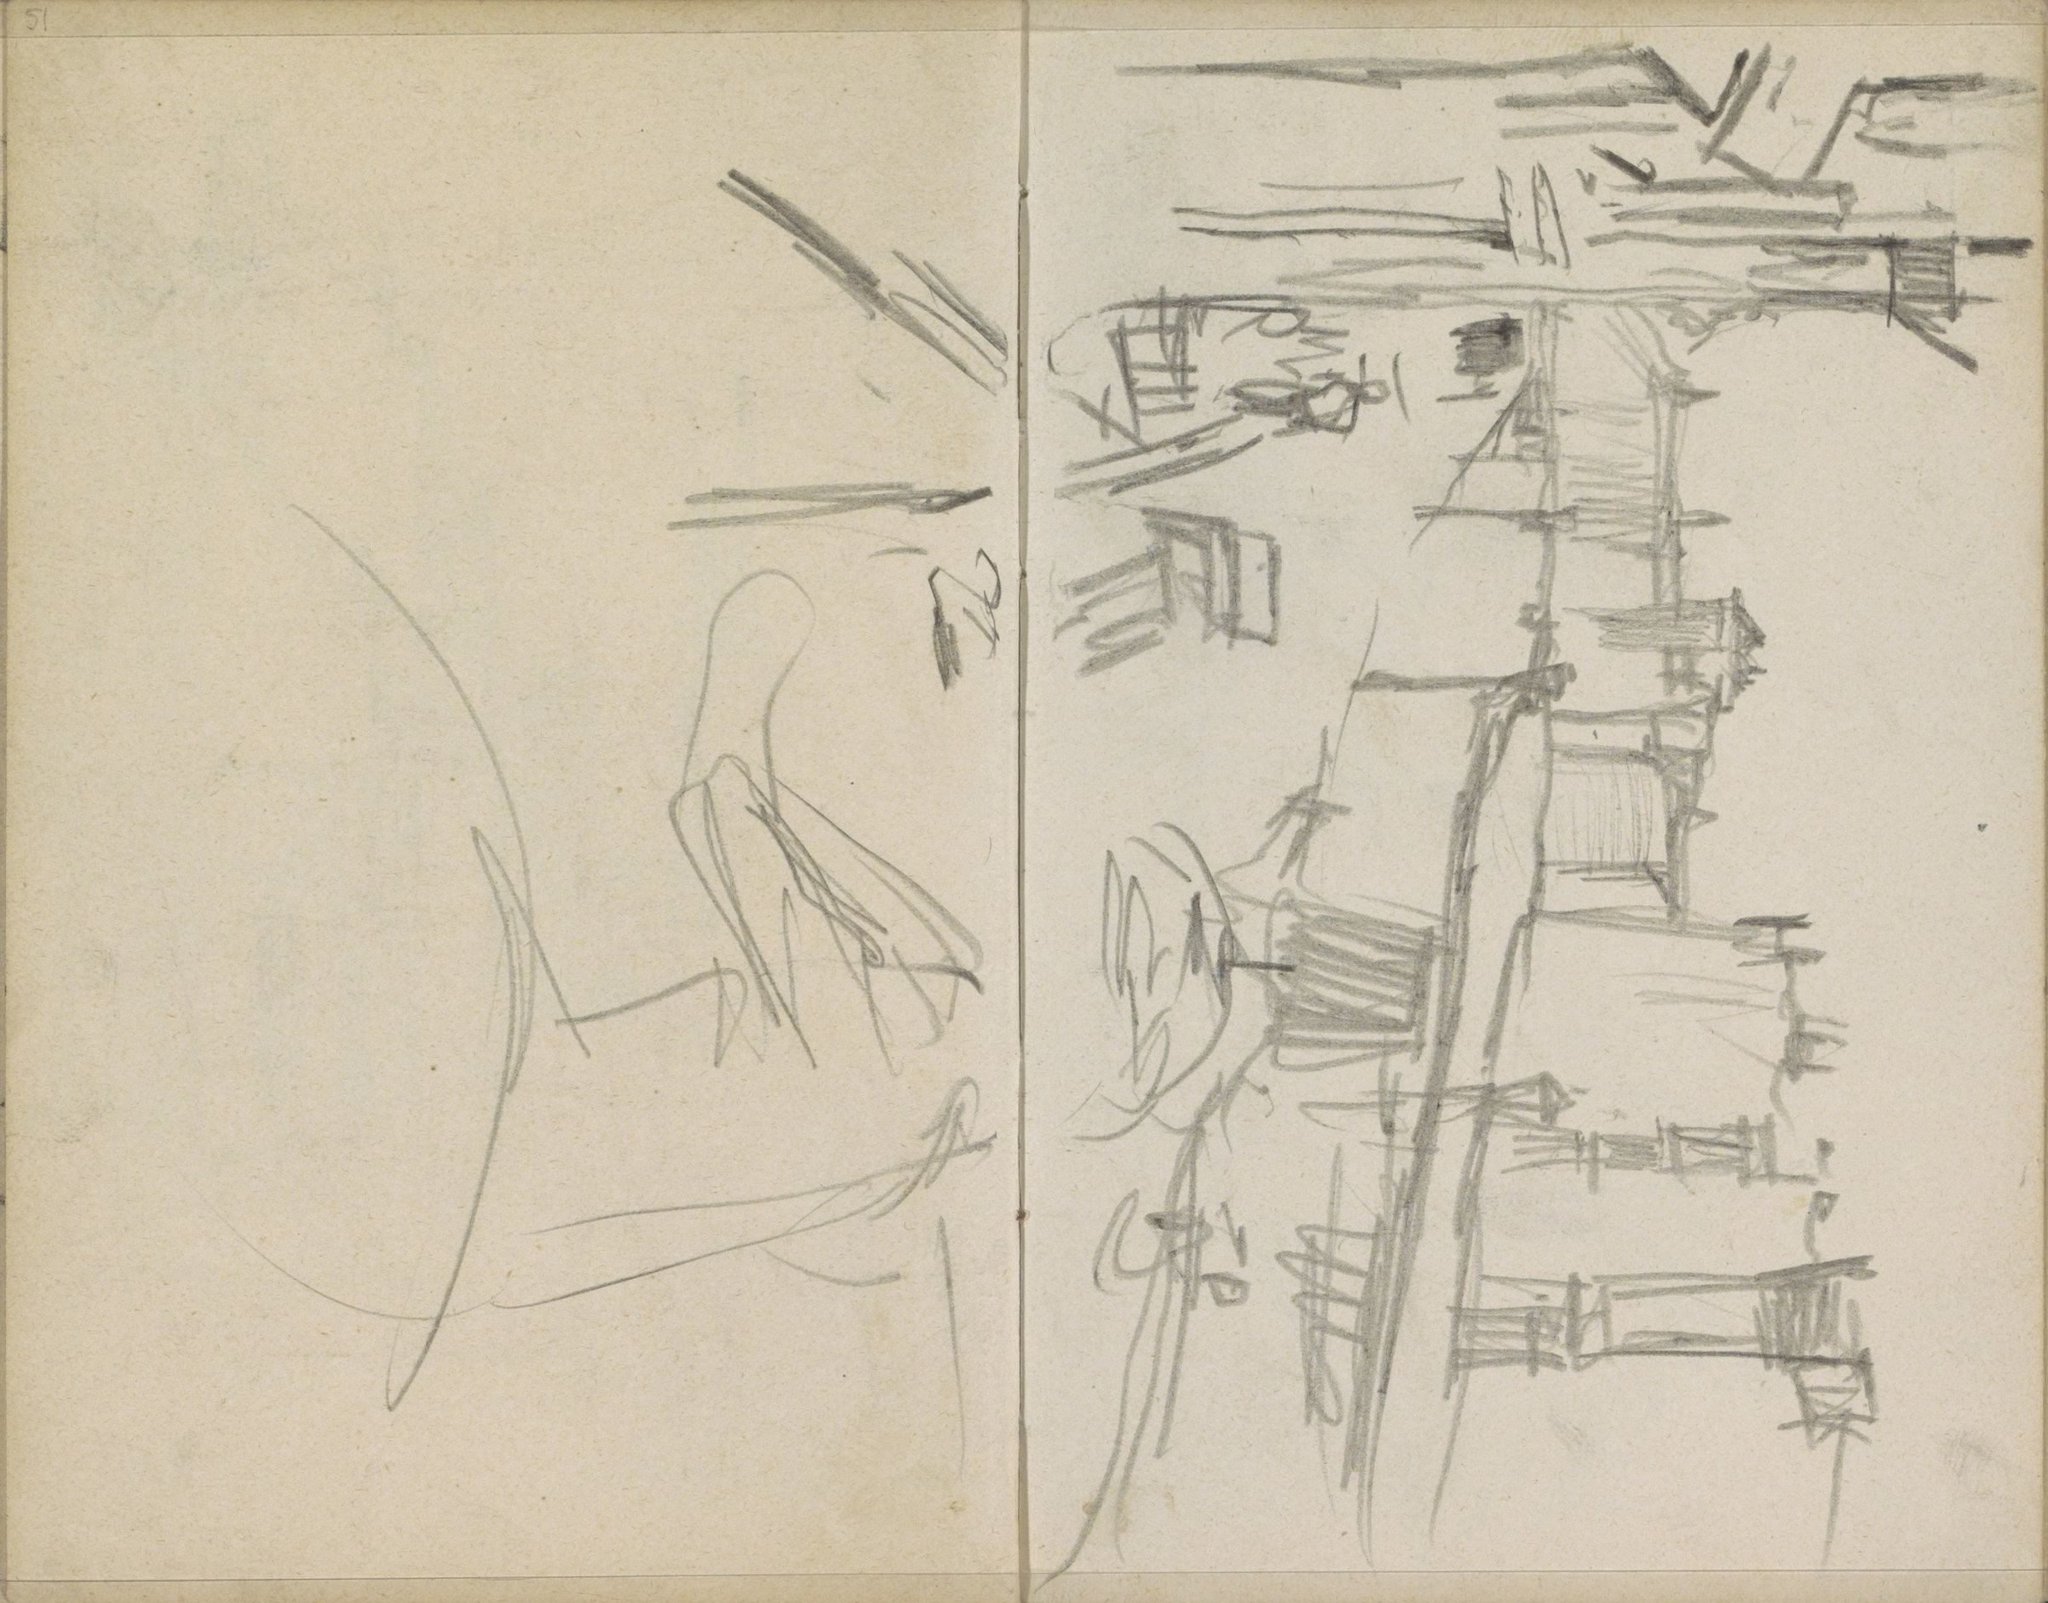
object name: sketchbook leaf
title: Gezicht op het Rokin te Amsterdam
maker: george hendrik breitner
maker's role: draughtsman, painter, print maker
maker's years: 1857-1923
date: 1902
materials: paper, pencil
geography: amsterdam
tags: urban housing, canals, waters (in city) (+ city(-scape) with figures, staffage)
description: Gezien vanuit de Bodega. Pagina 51 en pagina 52 uit een schetsboek met 46 bladen vervaardigd in de omgeving van Amsterdam, Rotterdam en Haarlem.